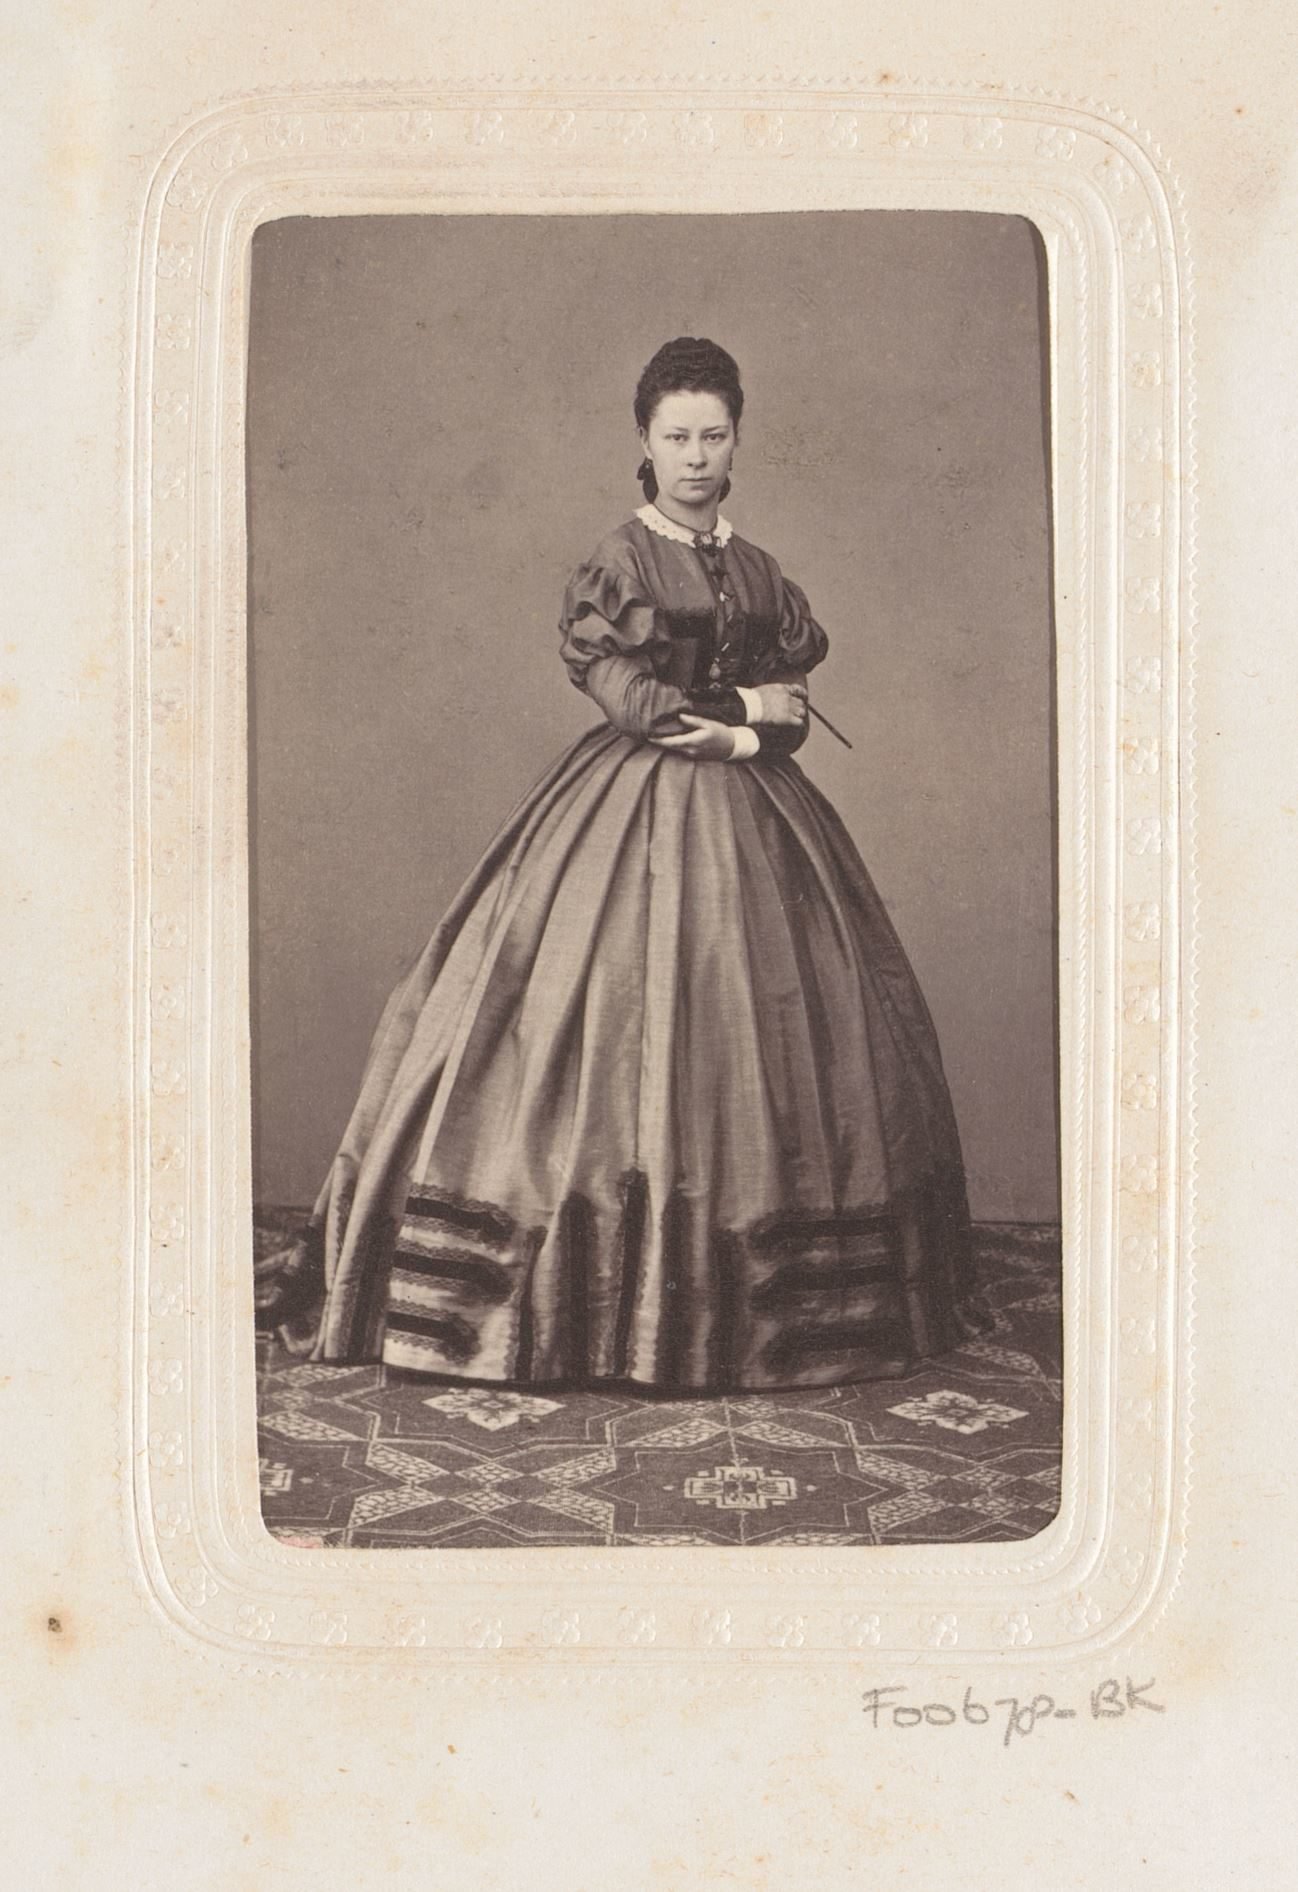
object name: carte de visite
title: Portret van een staande vrouw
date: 1860-1870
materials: cardboard, photographic support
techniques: albumen print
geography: salzburg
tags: historical persons - bb - woman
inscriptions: inscription: ‘Baldi & Würthle/ photographisches anstalt/ Salzburg/ Riedenburg, Villa Baldi, No. 17’